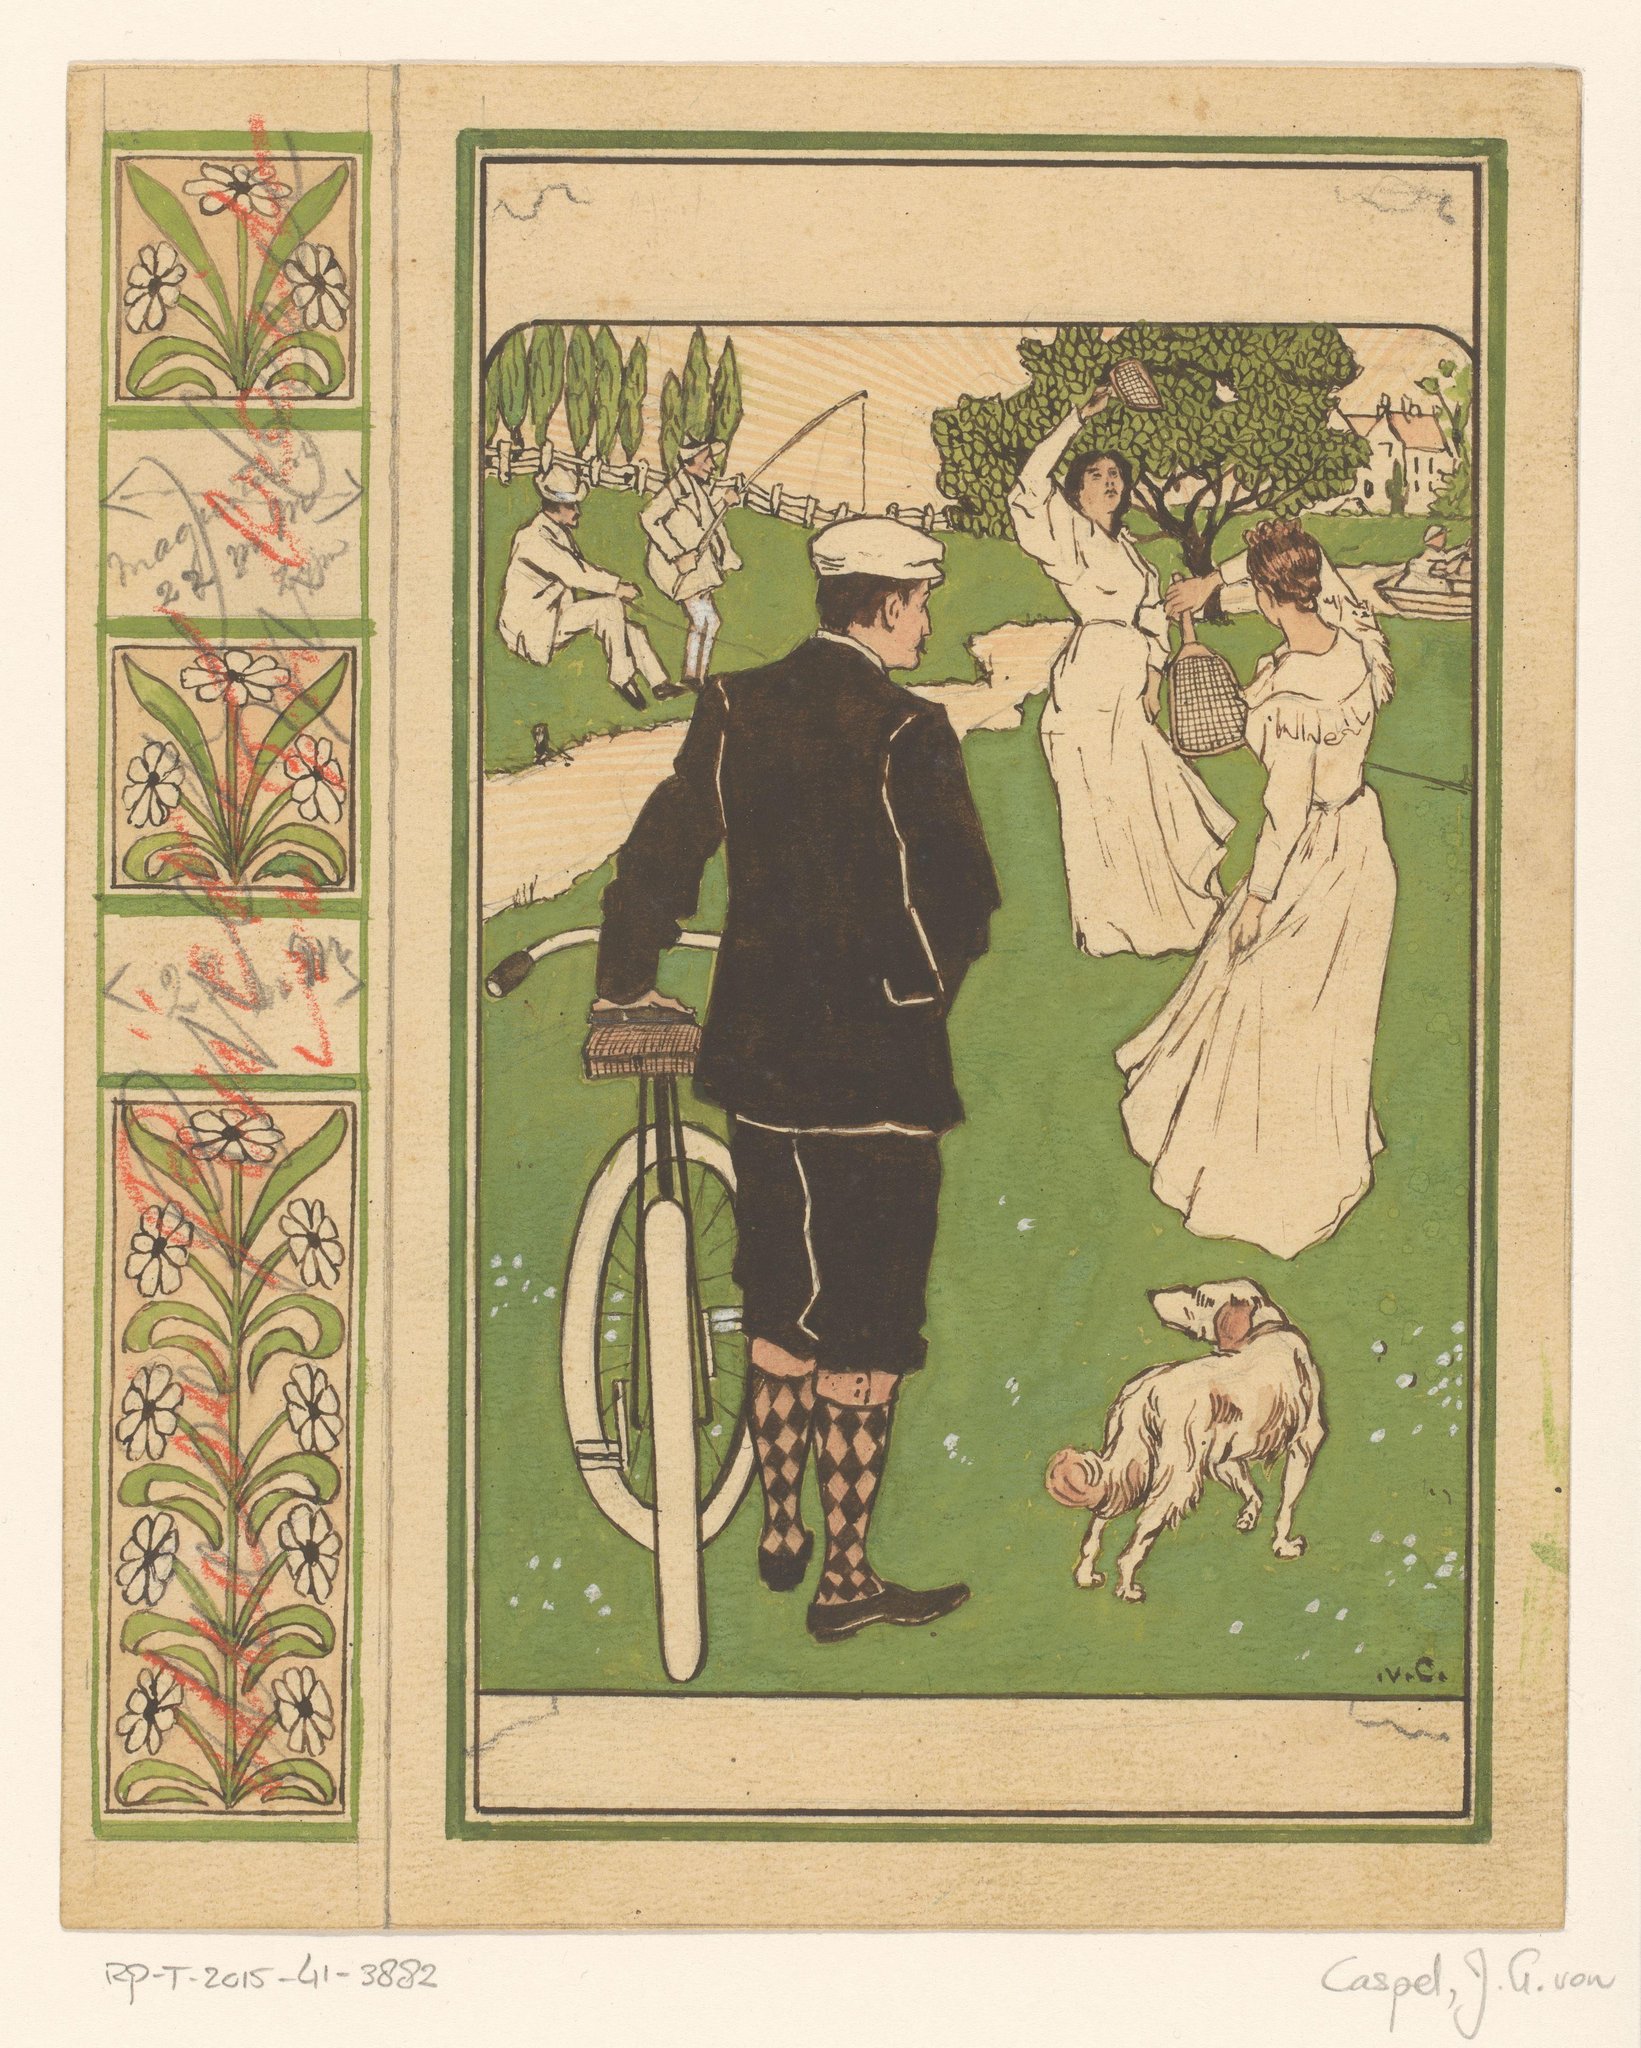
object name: drawing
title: Bandontwerp met man met fiets en badmintonspelers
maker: johann georg van caspel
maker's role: draughtsman, print maker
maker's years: 1870-1928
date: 1880-1928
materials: ink, paper, pencil, watercolor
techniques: brush, pen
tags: 'jeu de volant', badminton, bicycle, small canal, ditch (+ landscape with figures, staffage)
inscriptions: collector's mark: Lugt 2228a, signature: ‘.v.c.’, :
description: Een man staat met een fiets aan de hand op een grasveld langs een sloot. Twee vrouwen spelen badminton en twee mannen vissen. Op de boekrug bloemornamenten.